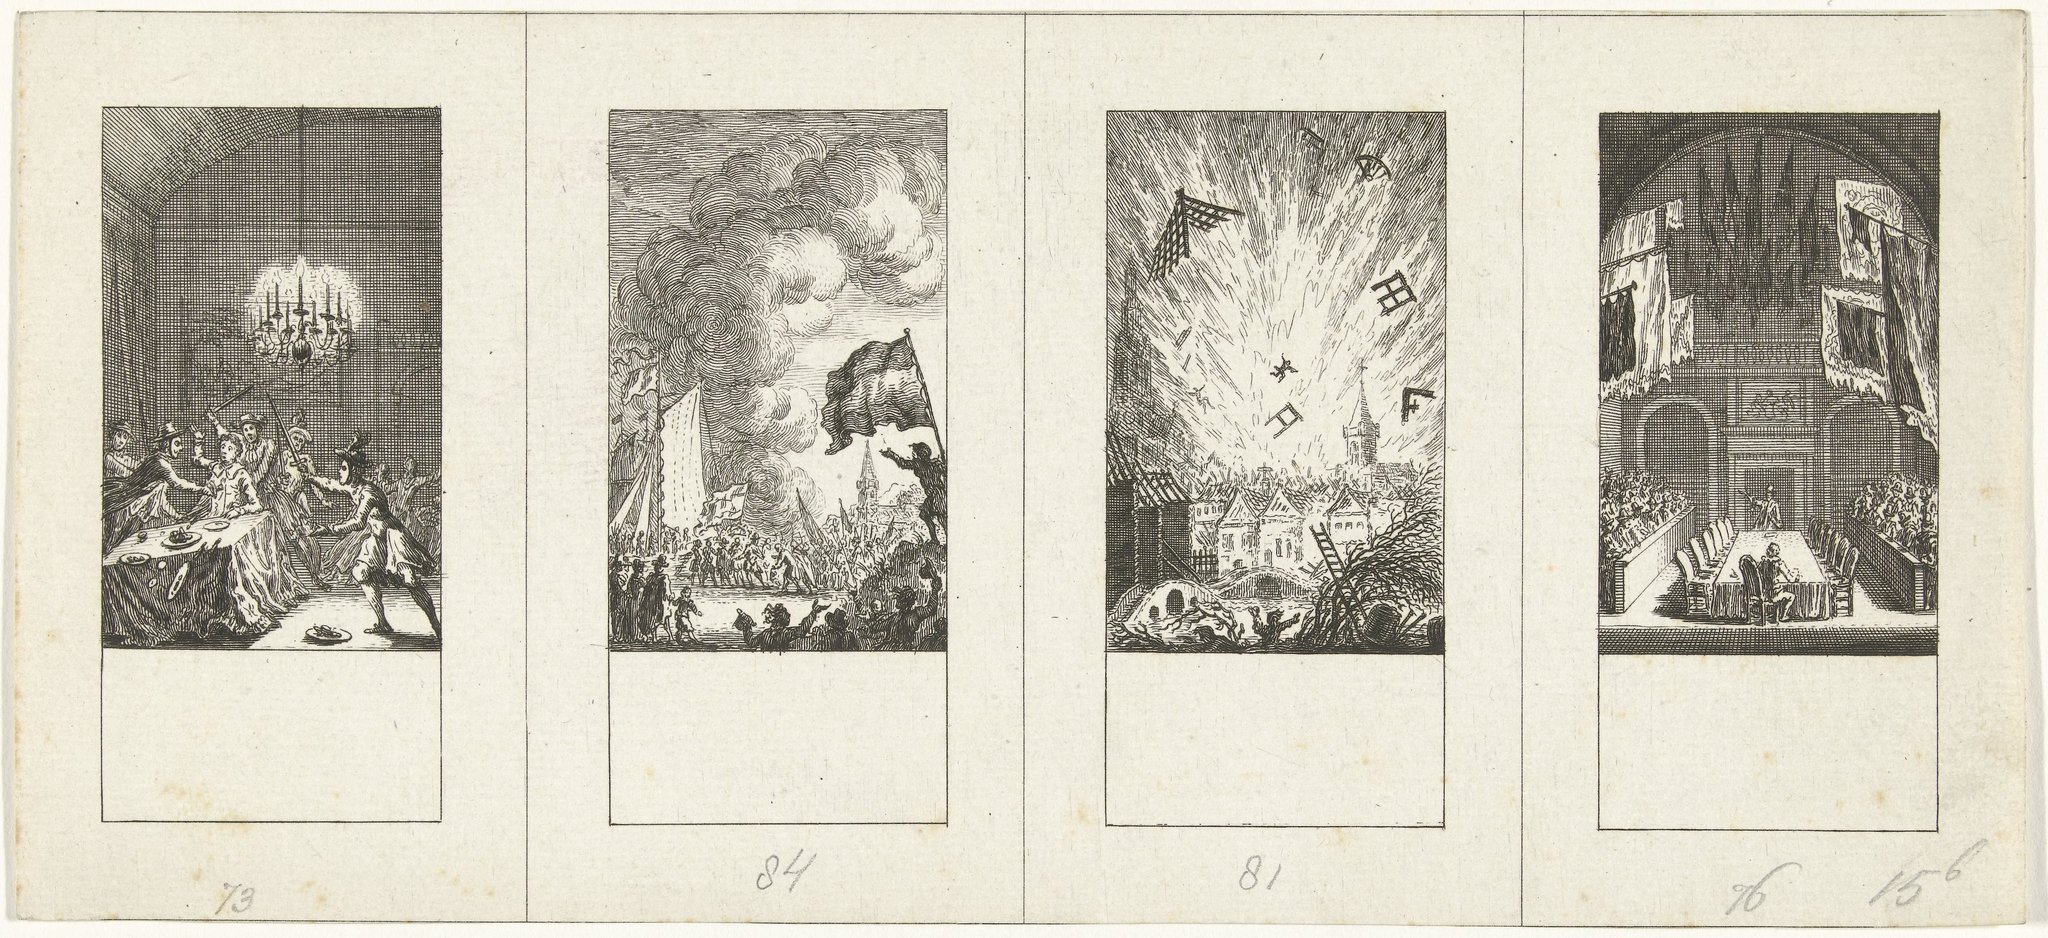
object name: print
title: Illustraties vaderlandse geschiedenis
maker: simon fokke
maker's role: draughtsman, print maker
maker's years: 1712-1784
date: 1722-1784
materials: paper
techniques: etching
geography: amsterdam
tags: enkhuizen, the hague, london, karel ii (koning van engeland), historical events and situations, historical persons (portraits and scenes from the life)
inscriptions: collector's mark: Lugt 2228, number: ‘73, 84, 81, 76’